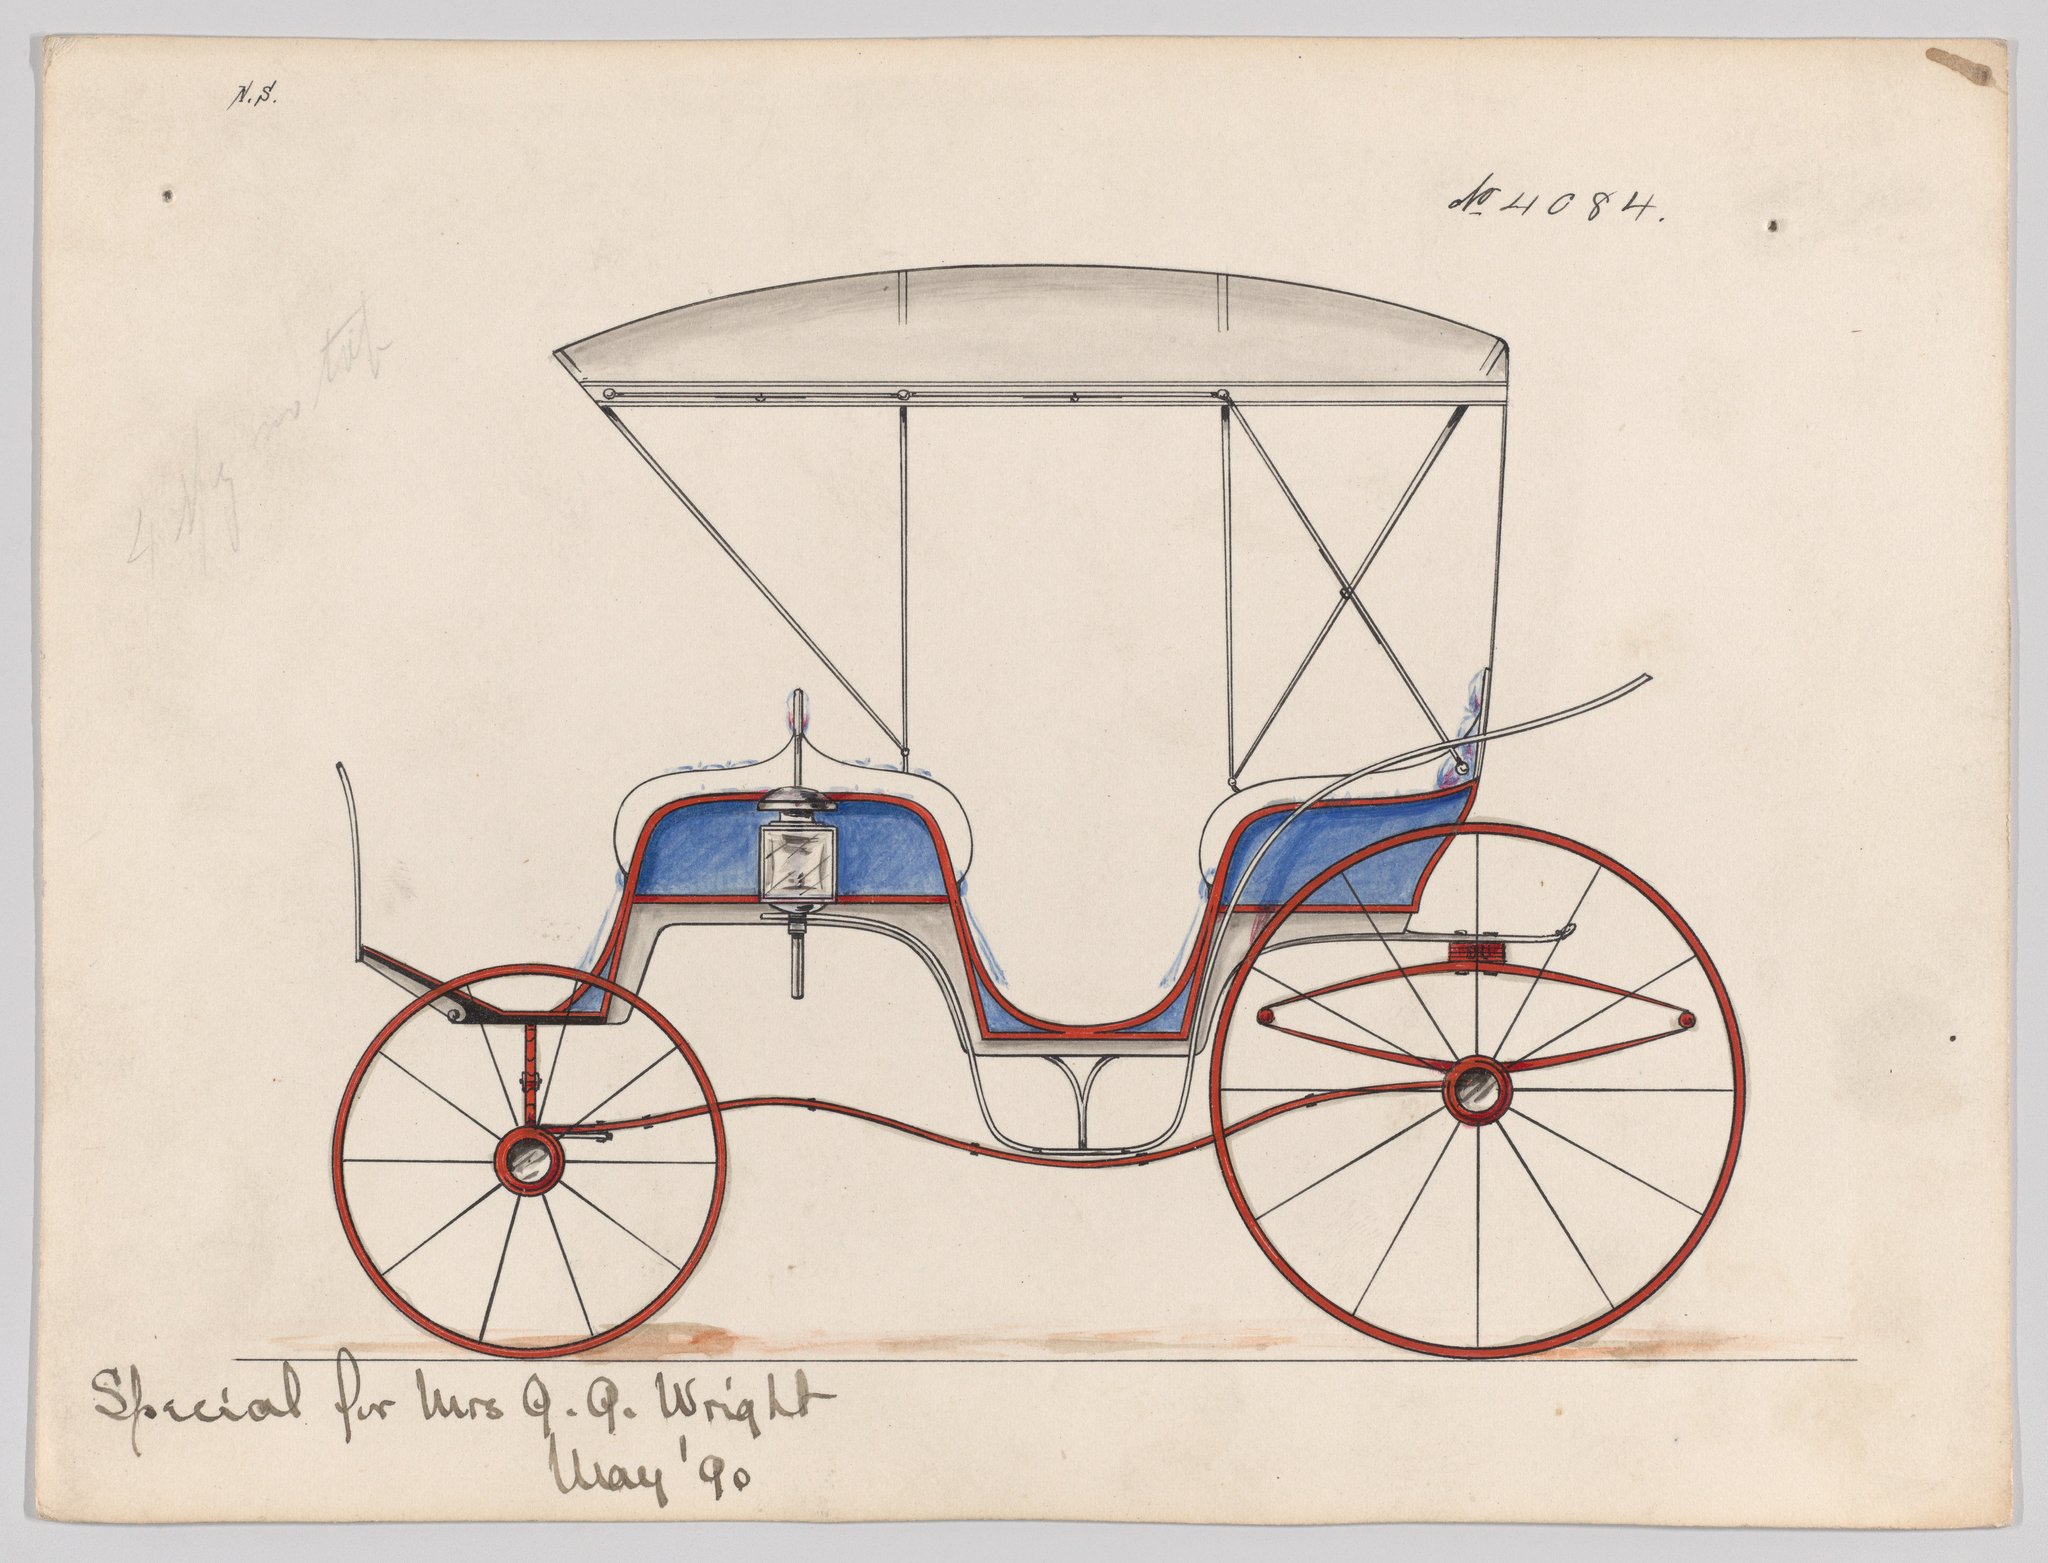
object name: drawing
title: Six Seat Phaeton #4084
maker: brewster & co.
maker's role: manufacturer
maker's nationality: american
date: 1890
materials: gouache, gum arabic, ink, watercolor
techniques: pen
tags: carriages